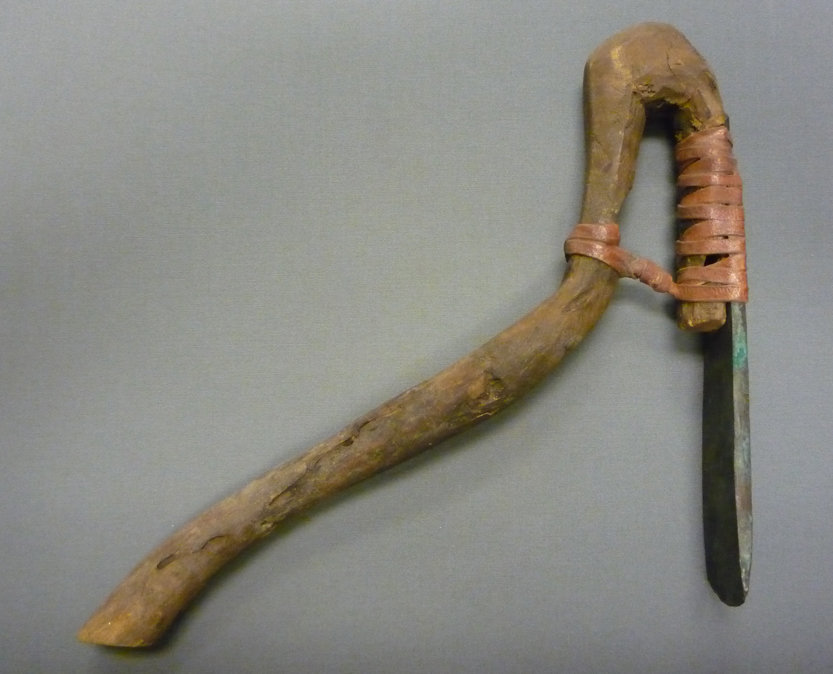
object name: adze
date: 1550-1295 BCE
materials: bronze, copper alloy, leather, wood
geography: egypt